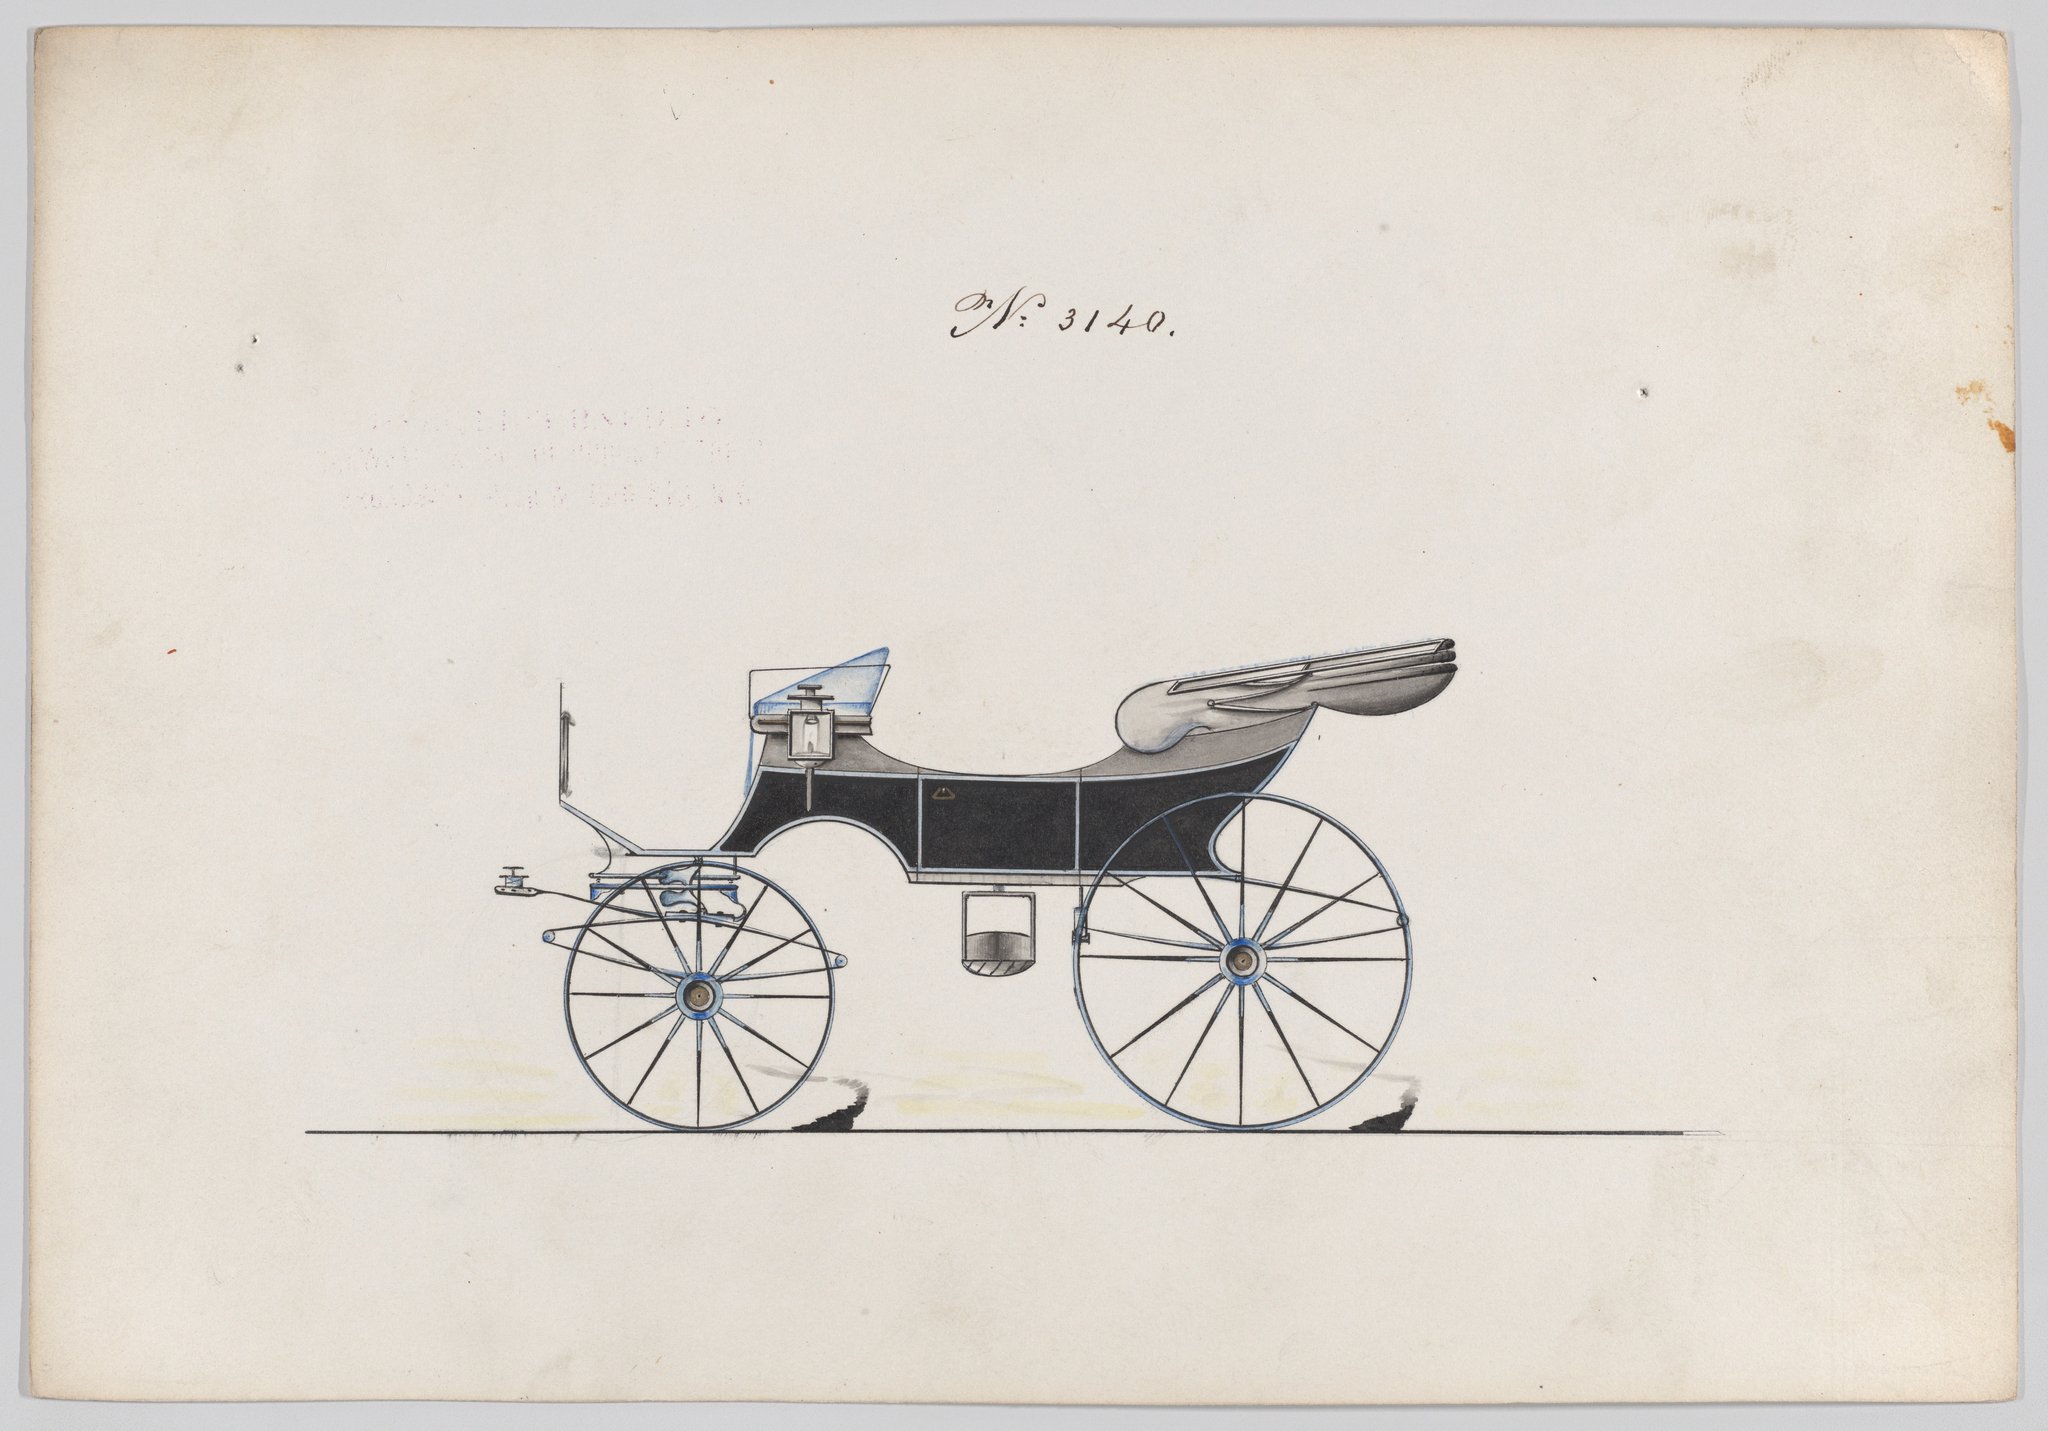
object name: drawing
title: Design for 2 seat or Cabriolet Phaeton, no. 3146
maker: brewster & co.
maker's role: manufacturer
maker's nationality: american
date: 1875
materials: gouache, ink, watercolor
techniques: pen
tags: carriages